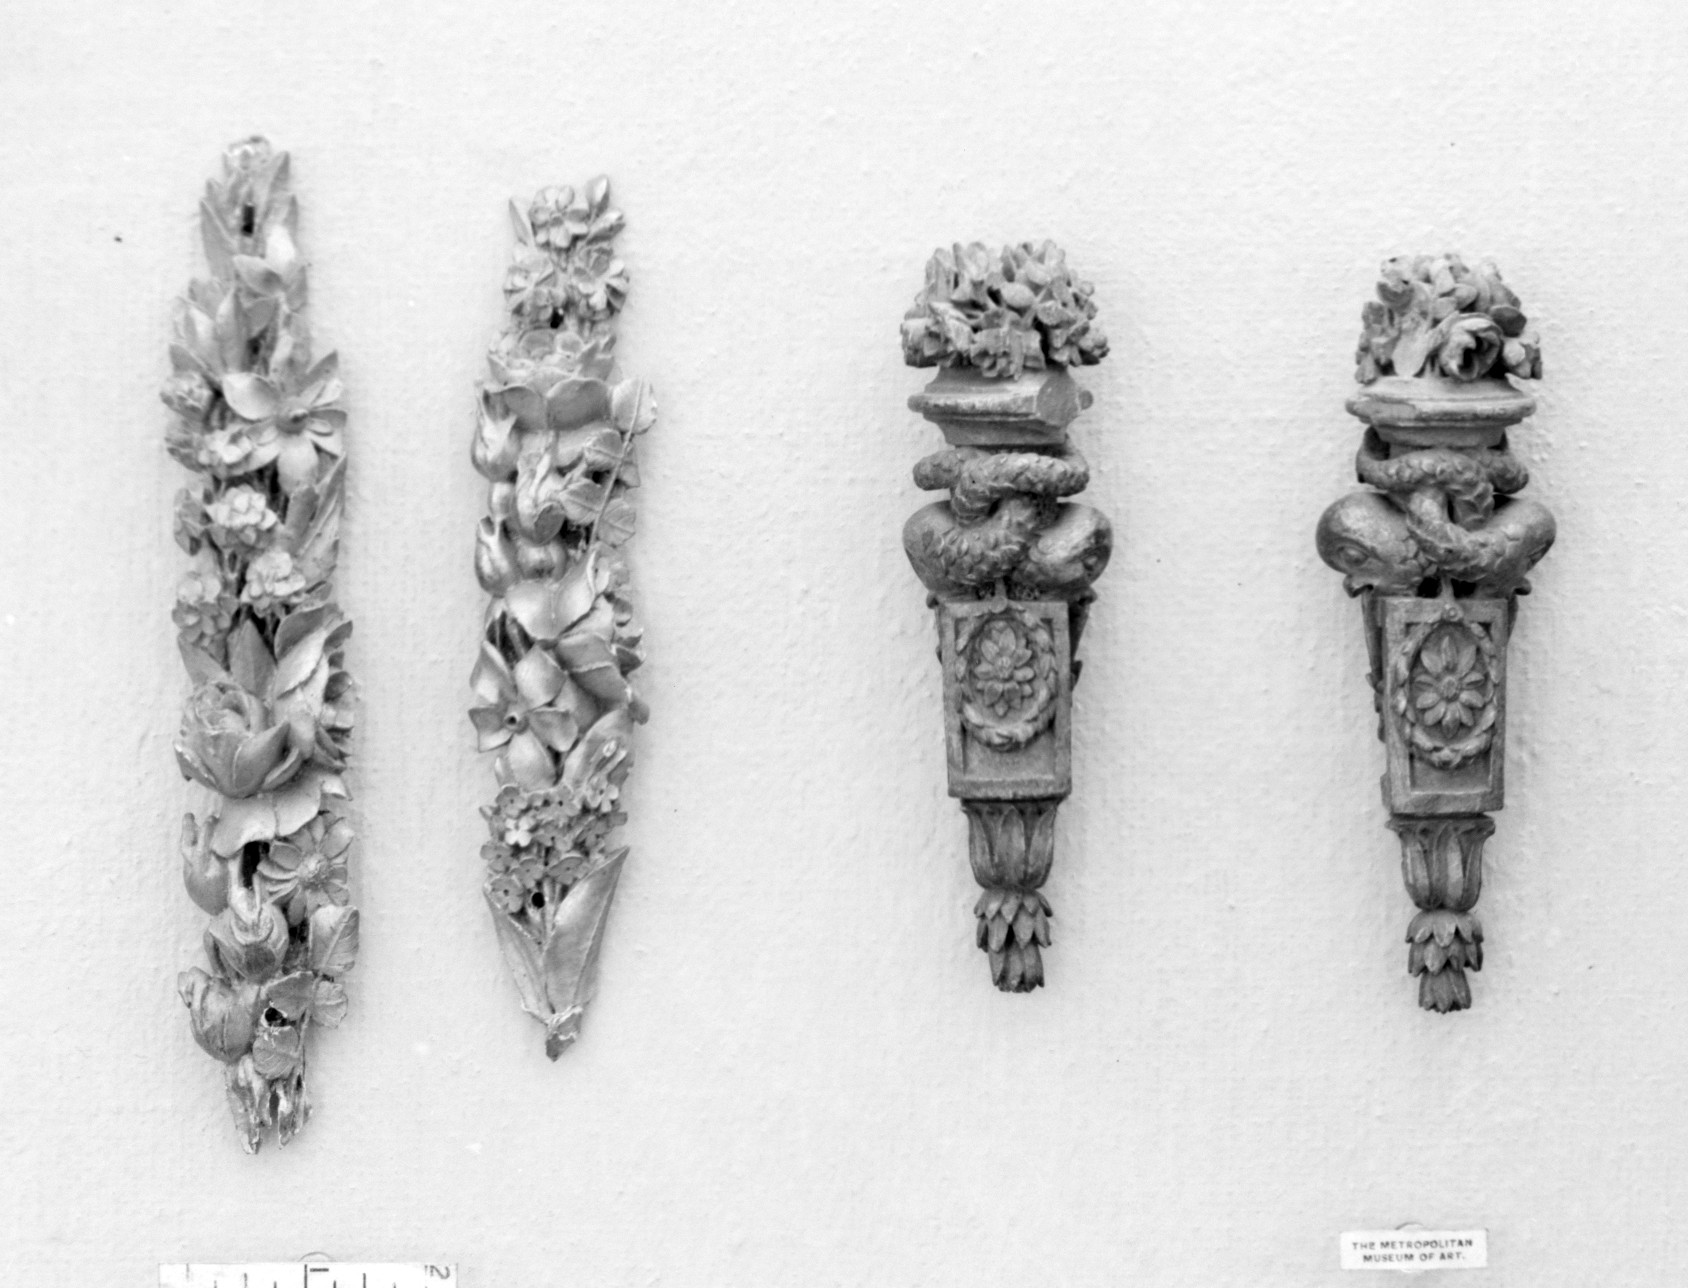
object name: garland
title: Pair of garlands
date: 1701-1800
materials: gilt, wood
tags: garlands,flowers